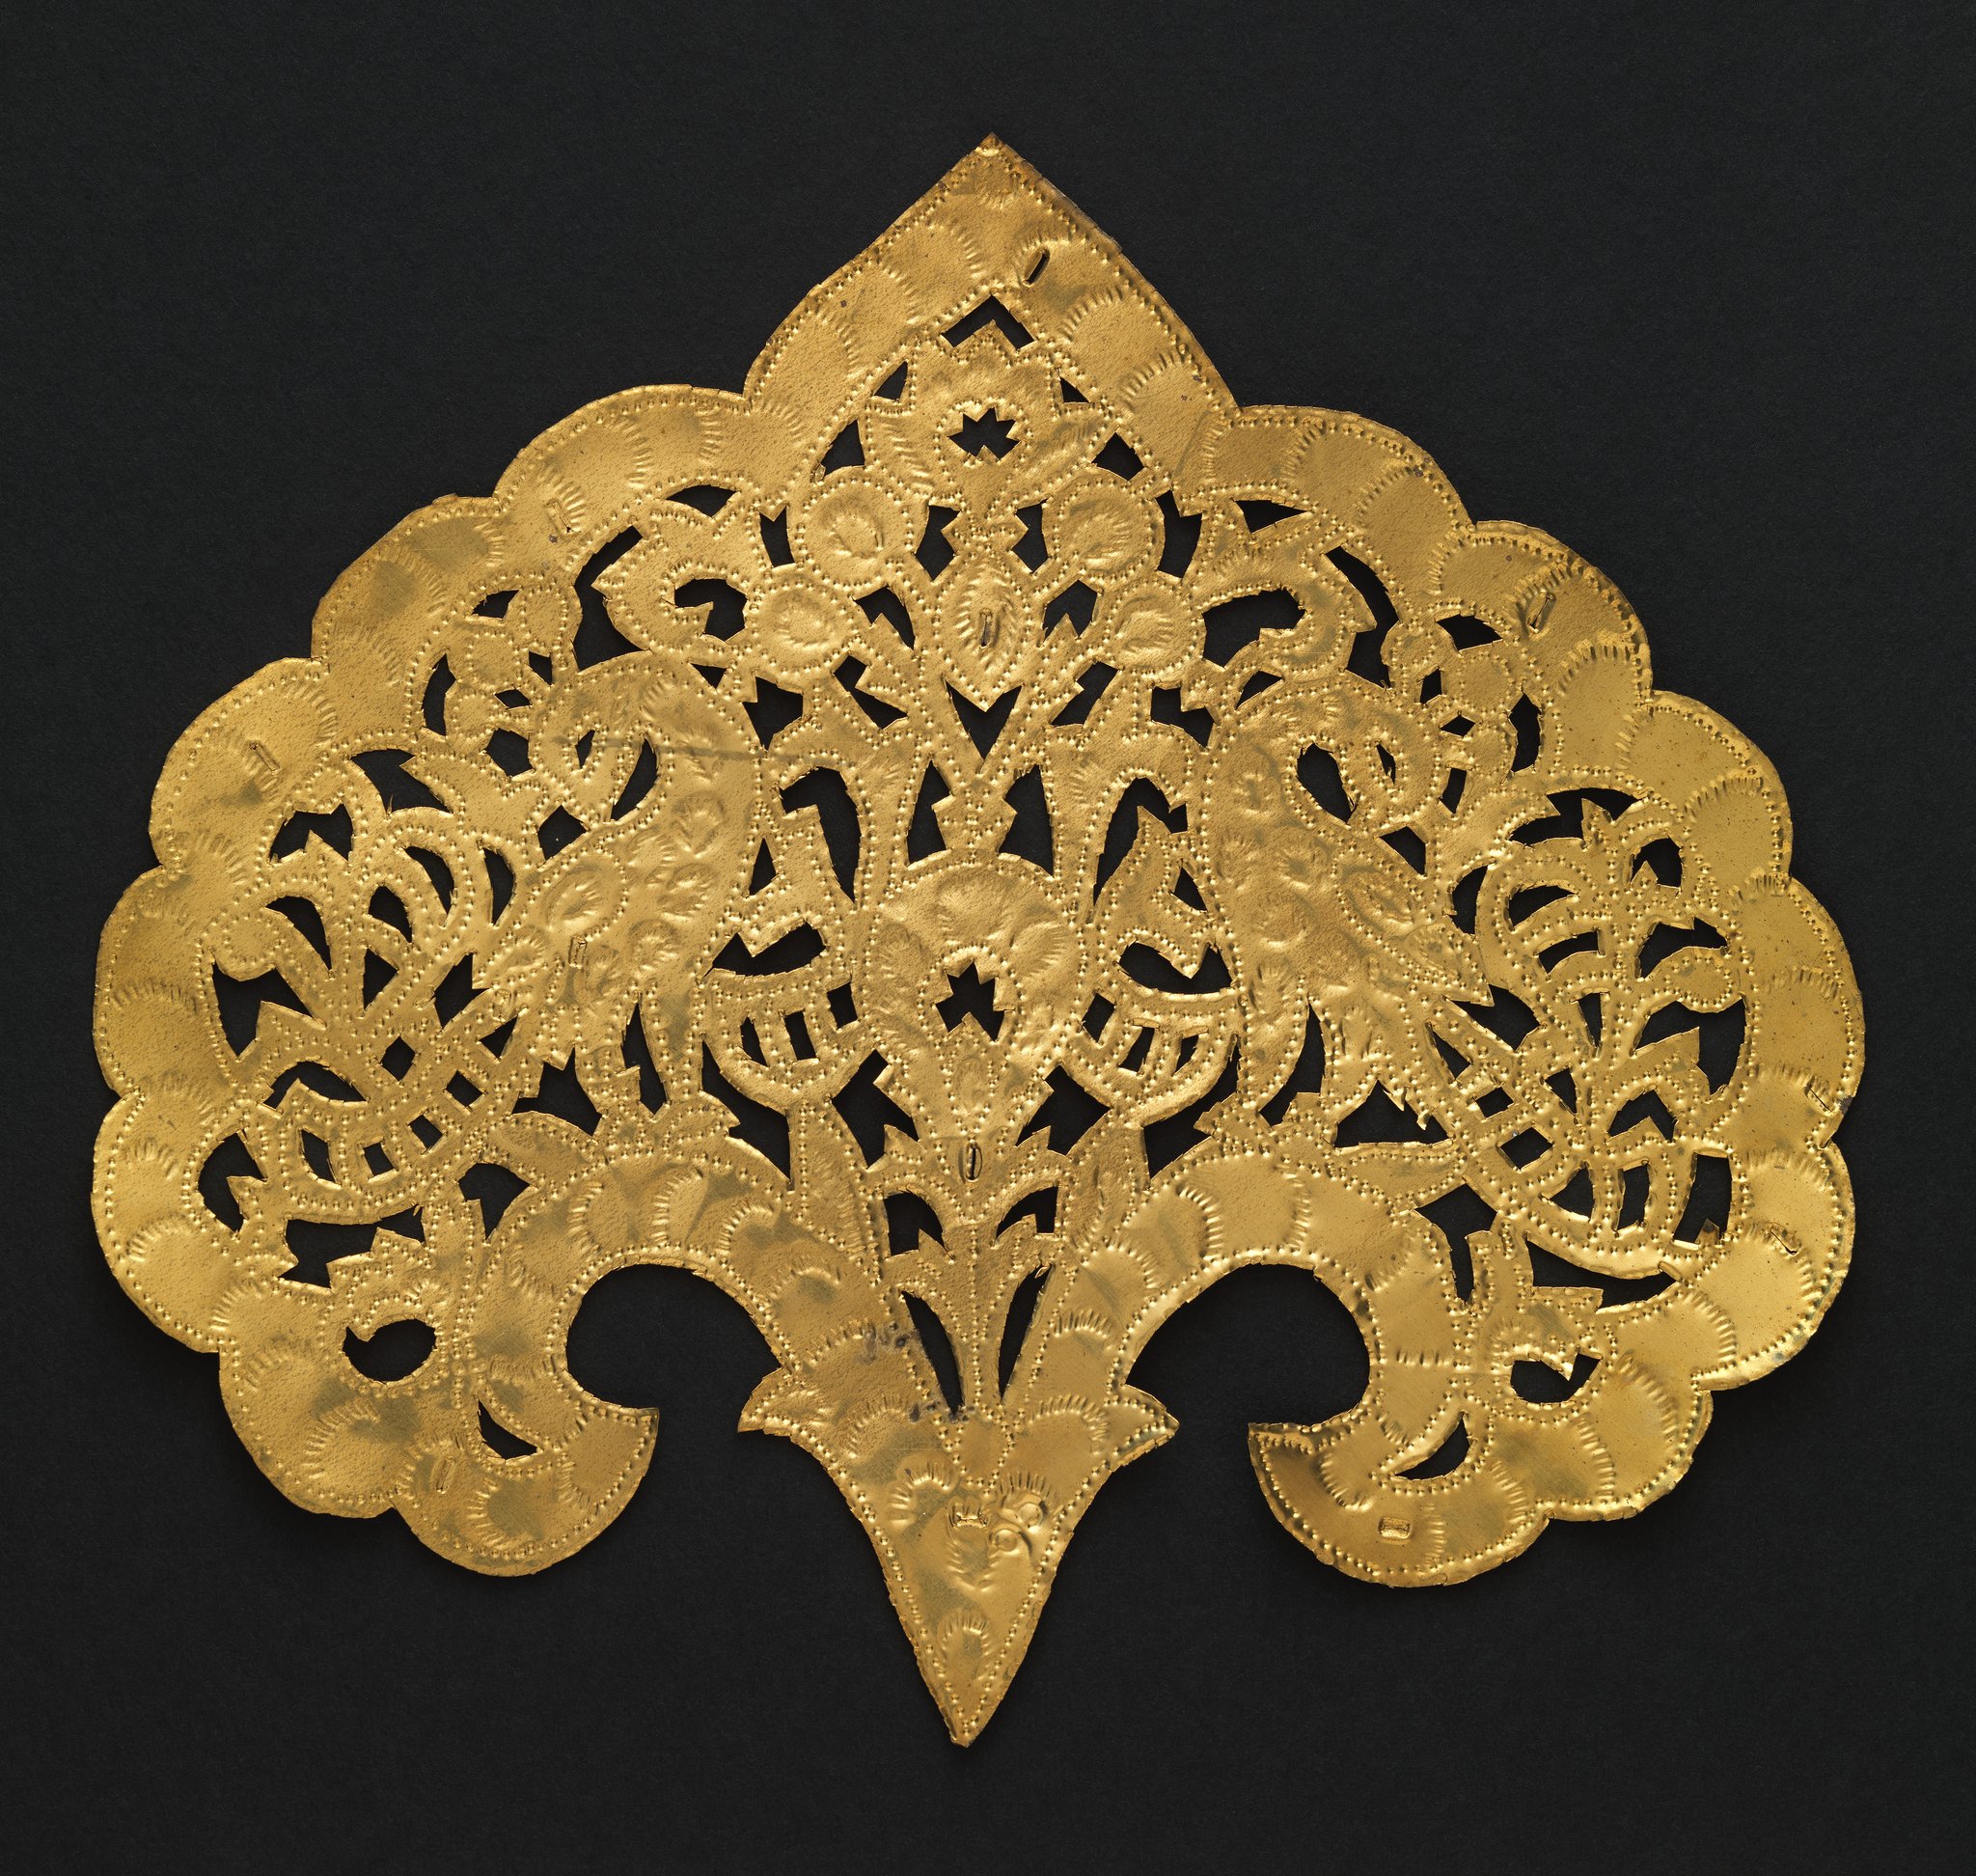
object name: cutout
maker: lockwood de forest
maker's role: designer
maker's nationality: american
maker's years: 1850-1932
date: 1892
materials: brass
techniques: chasing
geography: india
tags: ornament,peacocks